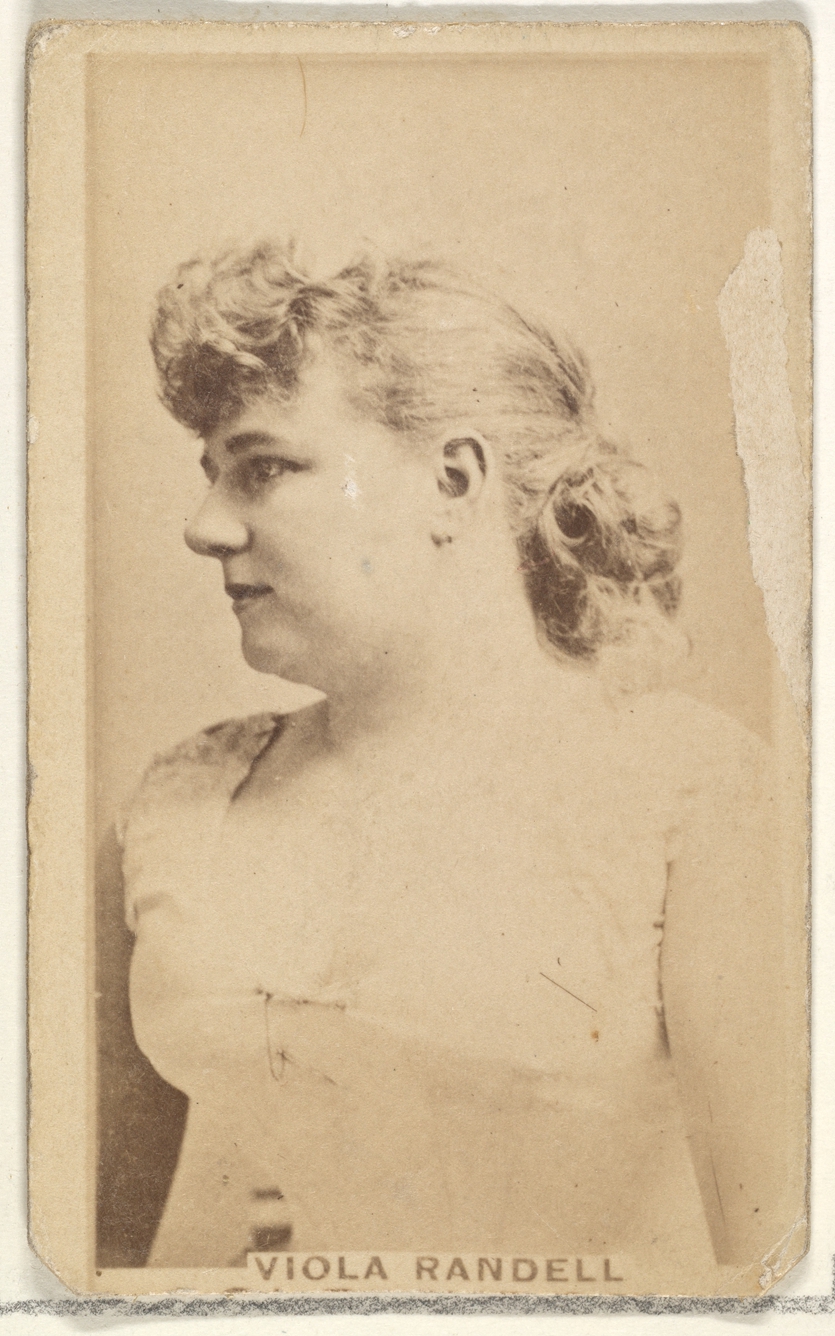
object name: photograph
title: Viola Randell, from the Actors and Actresses series (N45, Type 1) for Virginia Brights Cigarettes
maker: allen & ginter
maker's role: publisher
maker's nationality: american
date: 1888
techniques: albumen silver print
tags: portraits,profiles,women,actresses